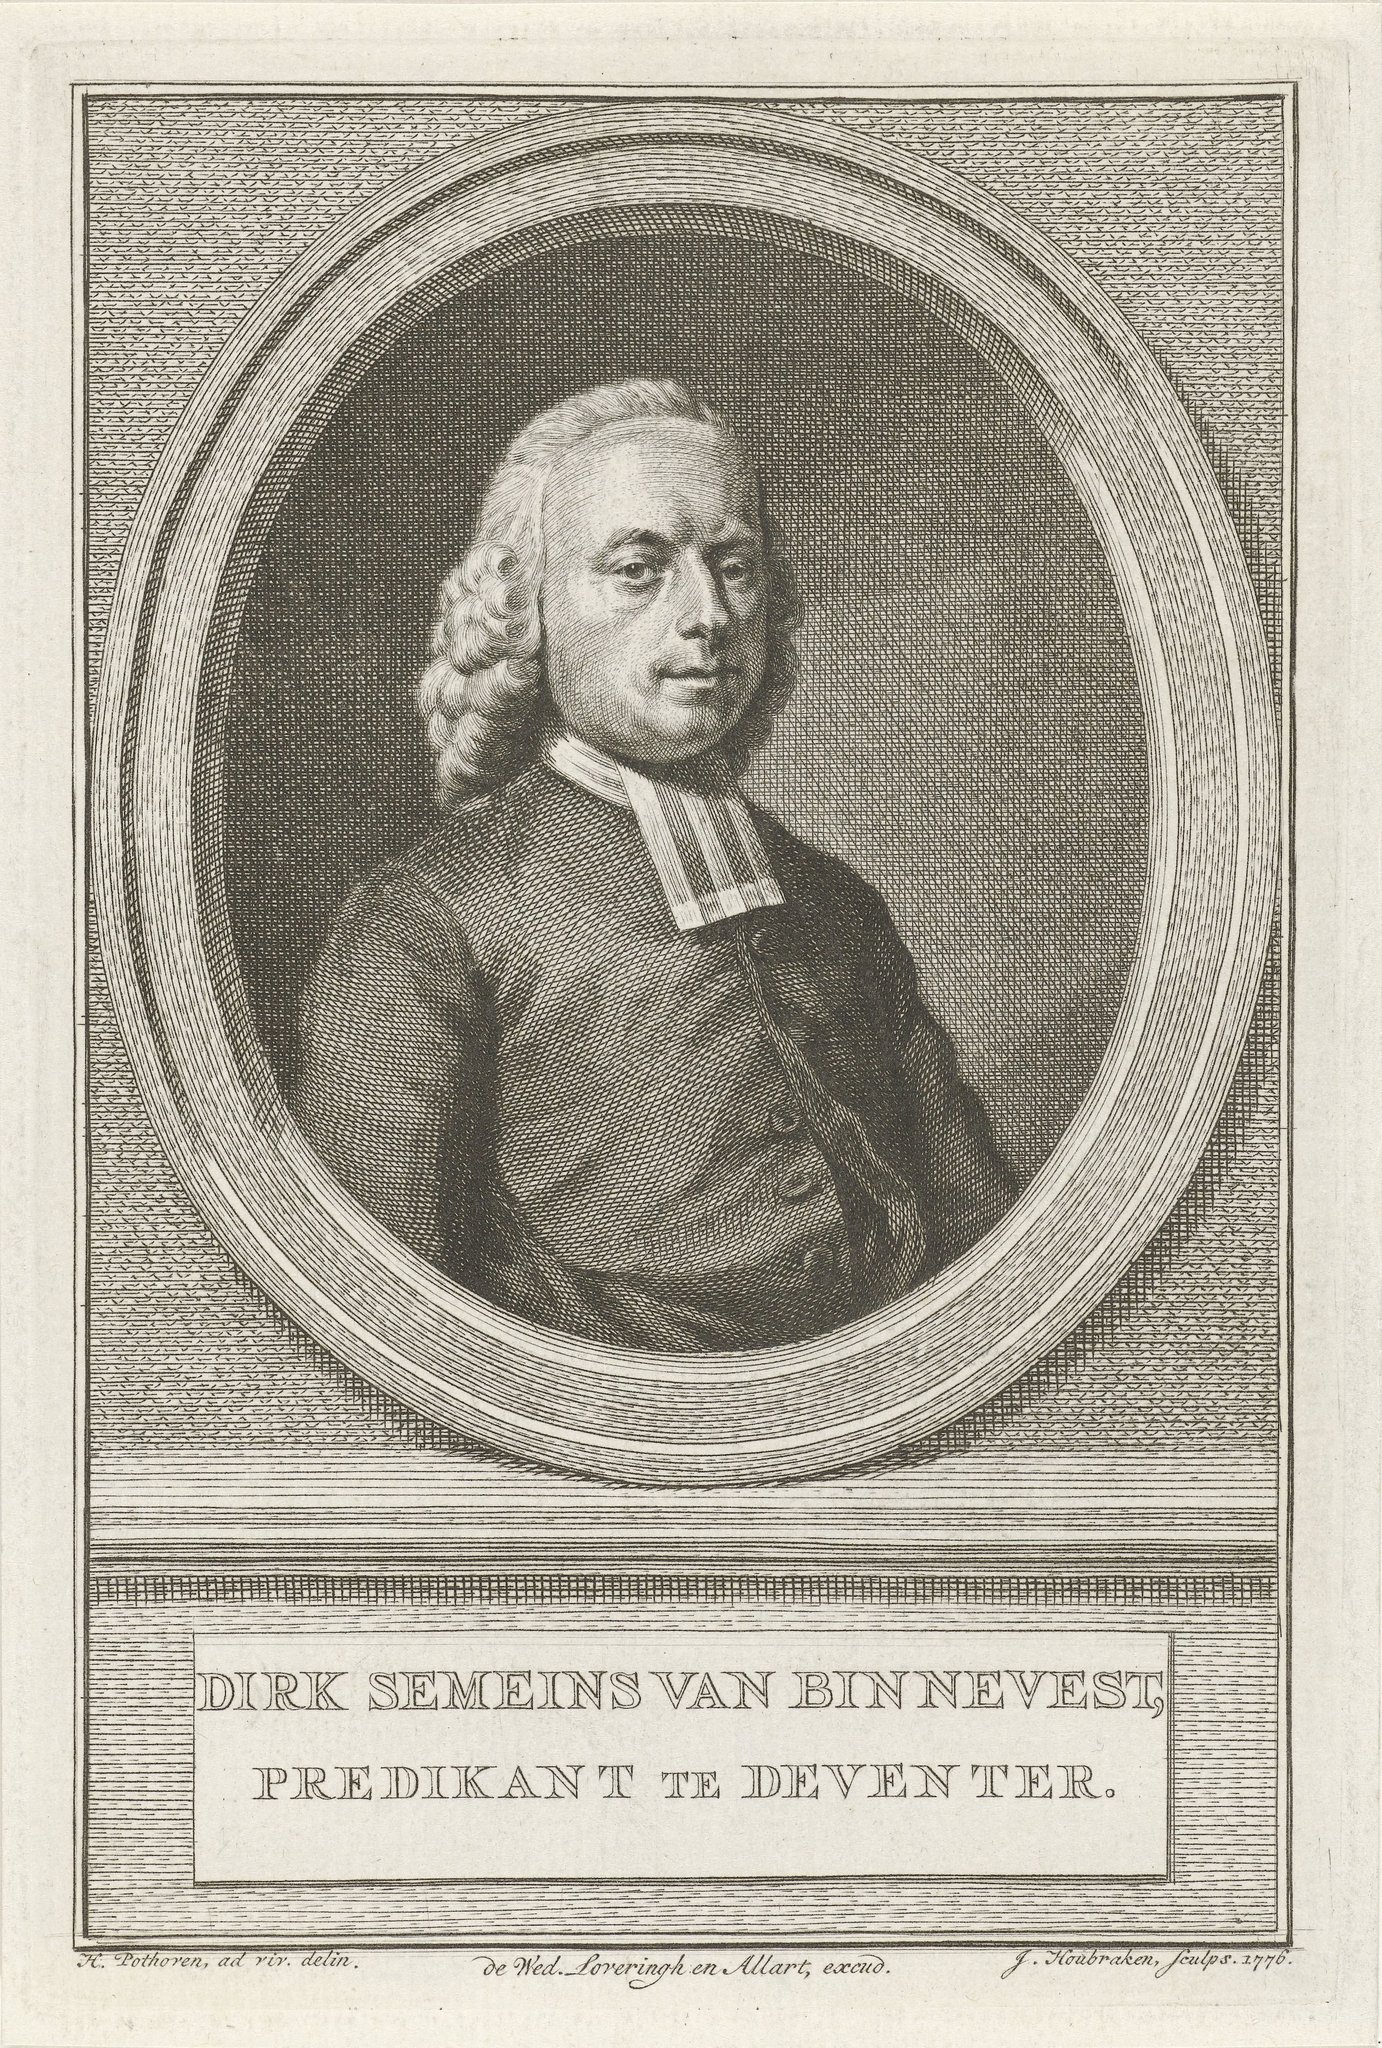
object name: print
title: Portret van Dirk Seimens van Binnevest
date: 1776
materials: paper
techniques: engraving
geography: amsterdam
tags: predikant, dirk seimens van binnevest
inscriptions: collector's mark: Lugt 2228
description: Prent volgens Ver Huell ook gebruikt in: Josua van Iperen, Kerkelyke historie van het psalm-gezang der christenen (...) en inzonderheid van onze verbeterde Nederduitsche psalmberyminge. Amsterdam: wed. Loveringh en Allart, 1777. Deel 2: J. Allart, 1778.